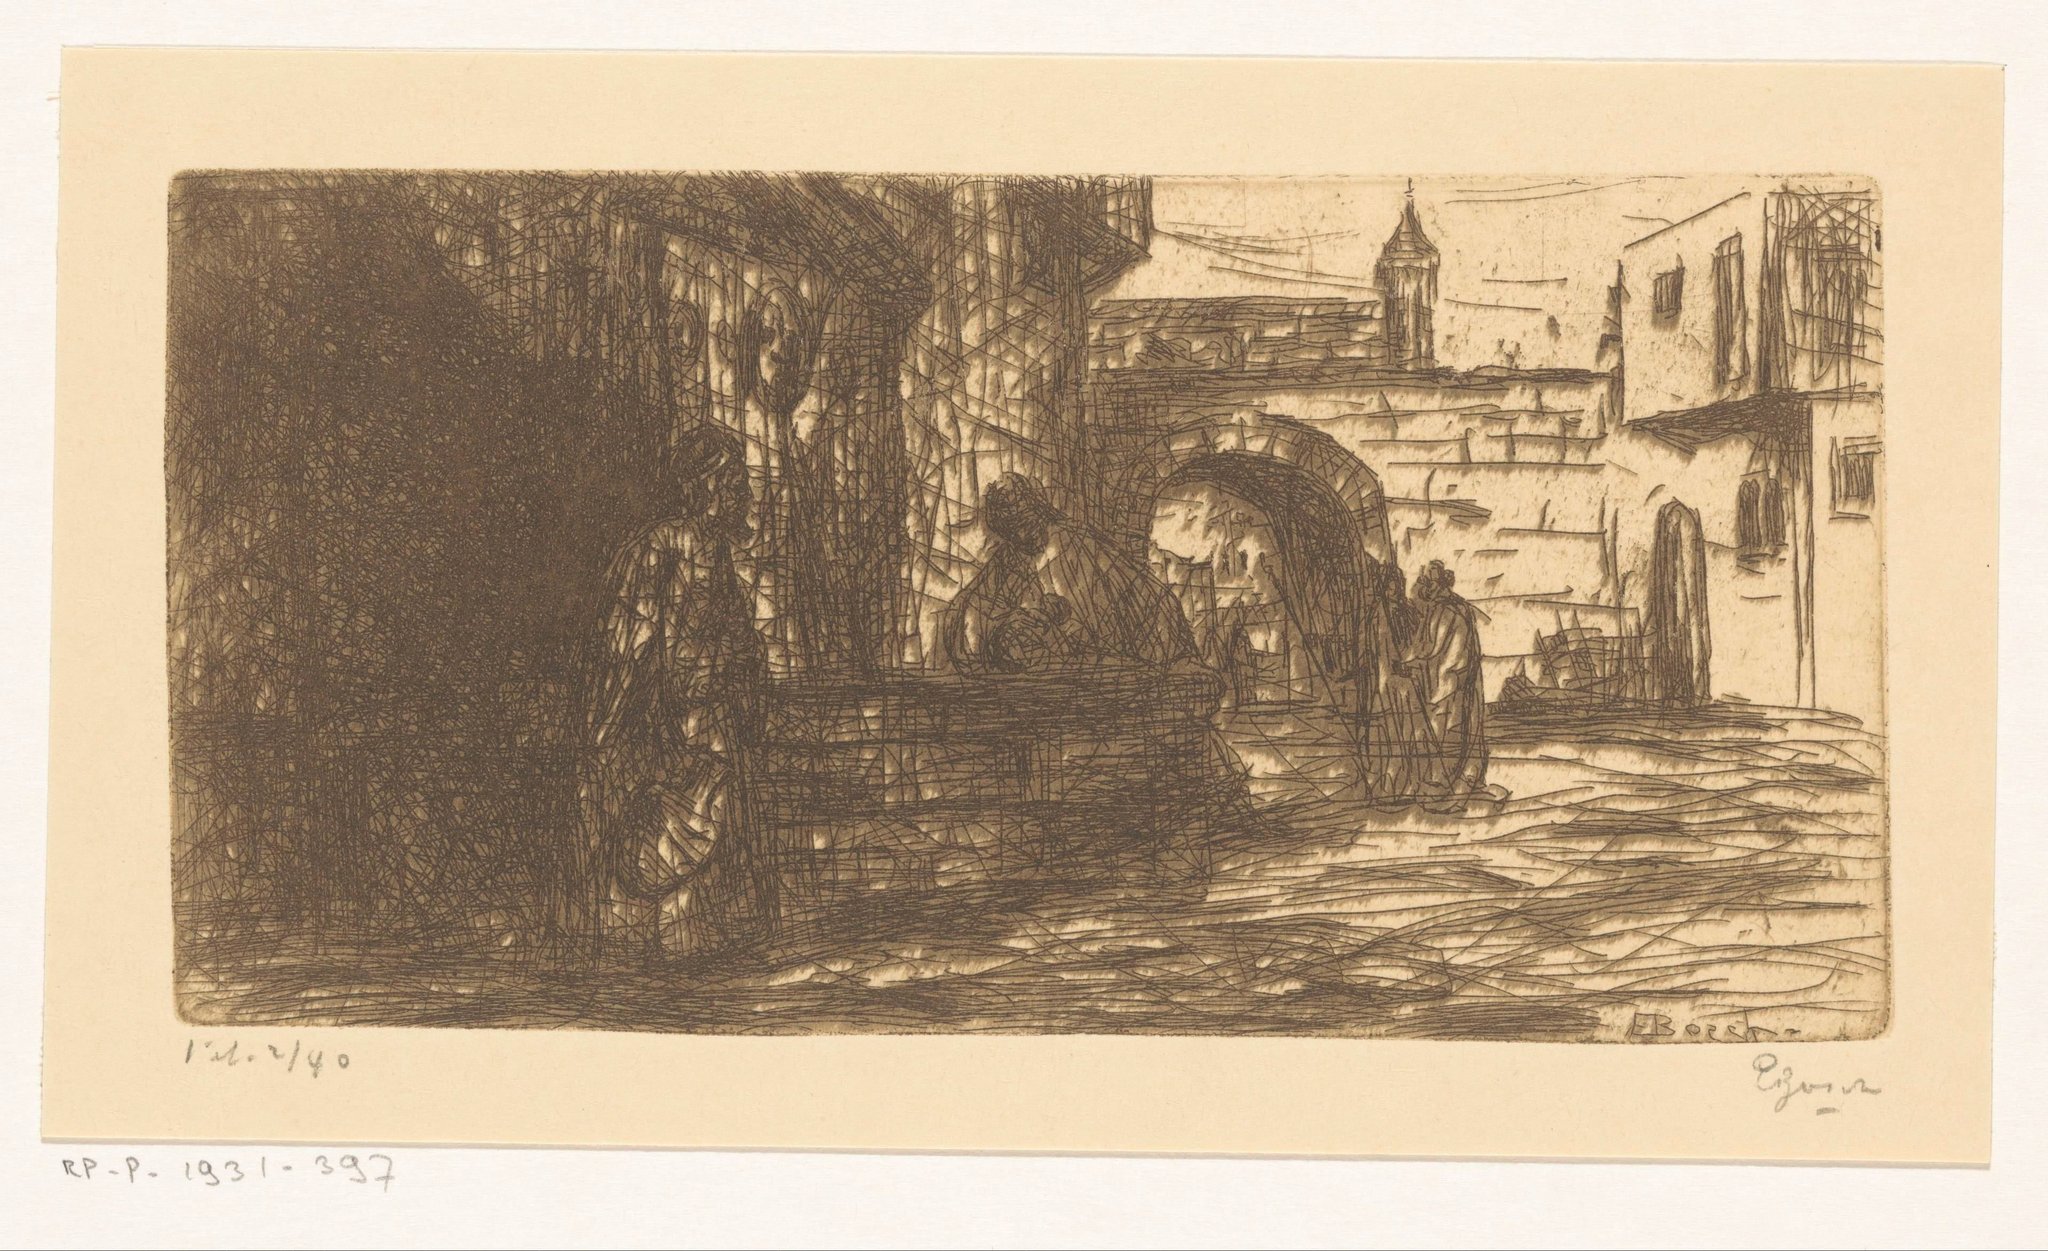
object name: print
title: Oberammergau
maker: etienne bosch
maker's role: print maker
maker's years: 1863-1933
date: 1873-1931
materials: paper, ink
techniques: drypoint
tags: oberammergau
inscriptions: signature: ‘EBosch’, collector's mark: Lugt 2228, edition: ‘1e et. 2/40’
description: Gezicht op een steeg met enkele figuren, met op de achtergrond een poort en een toren.